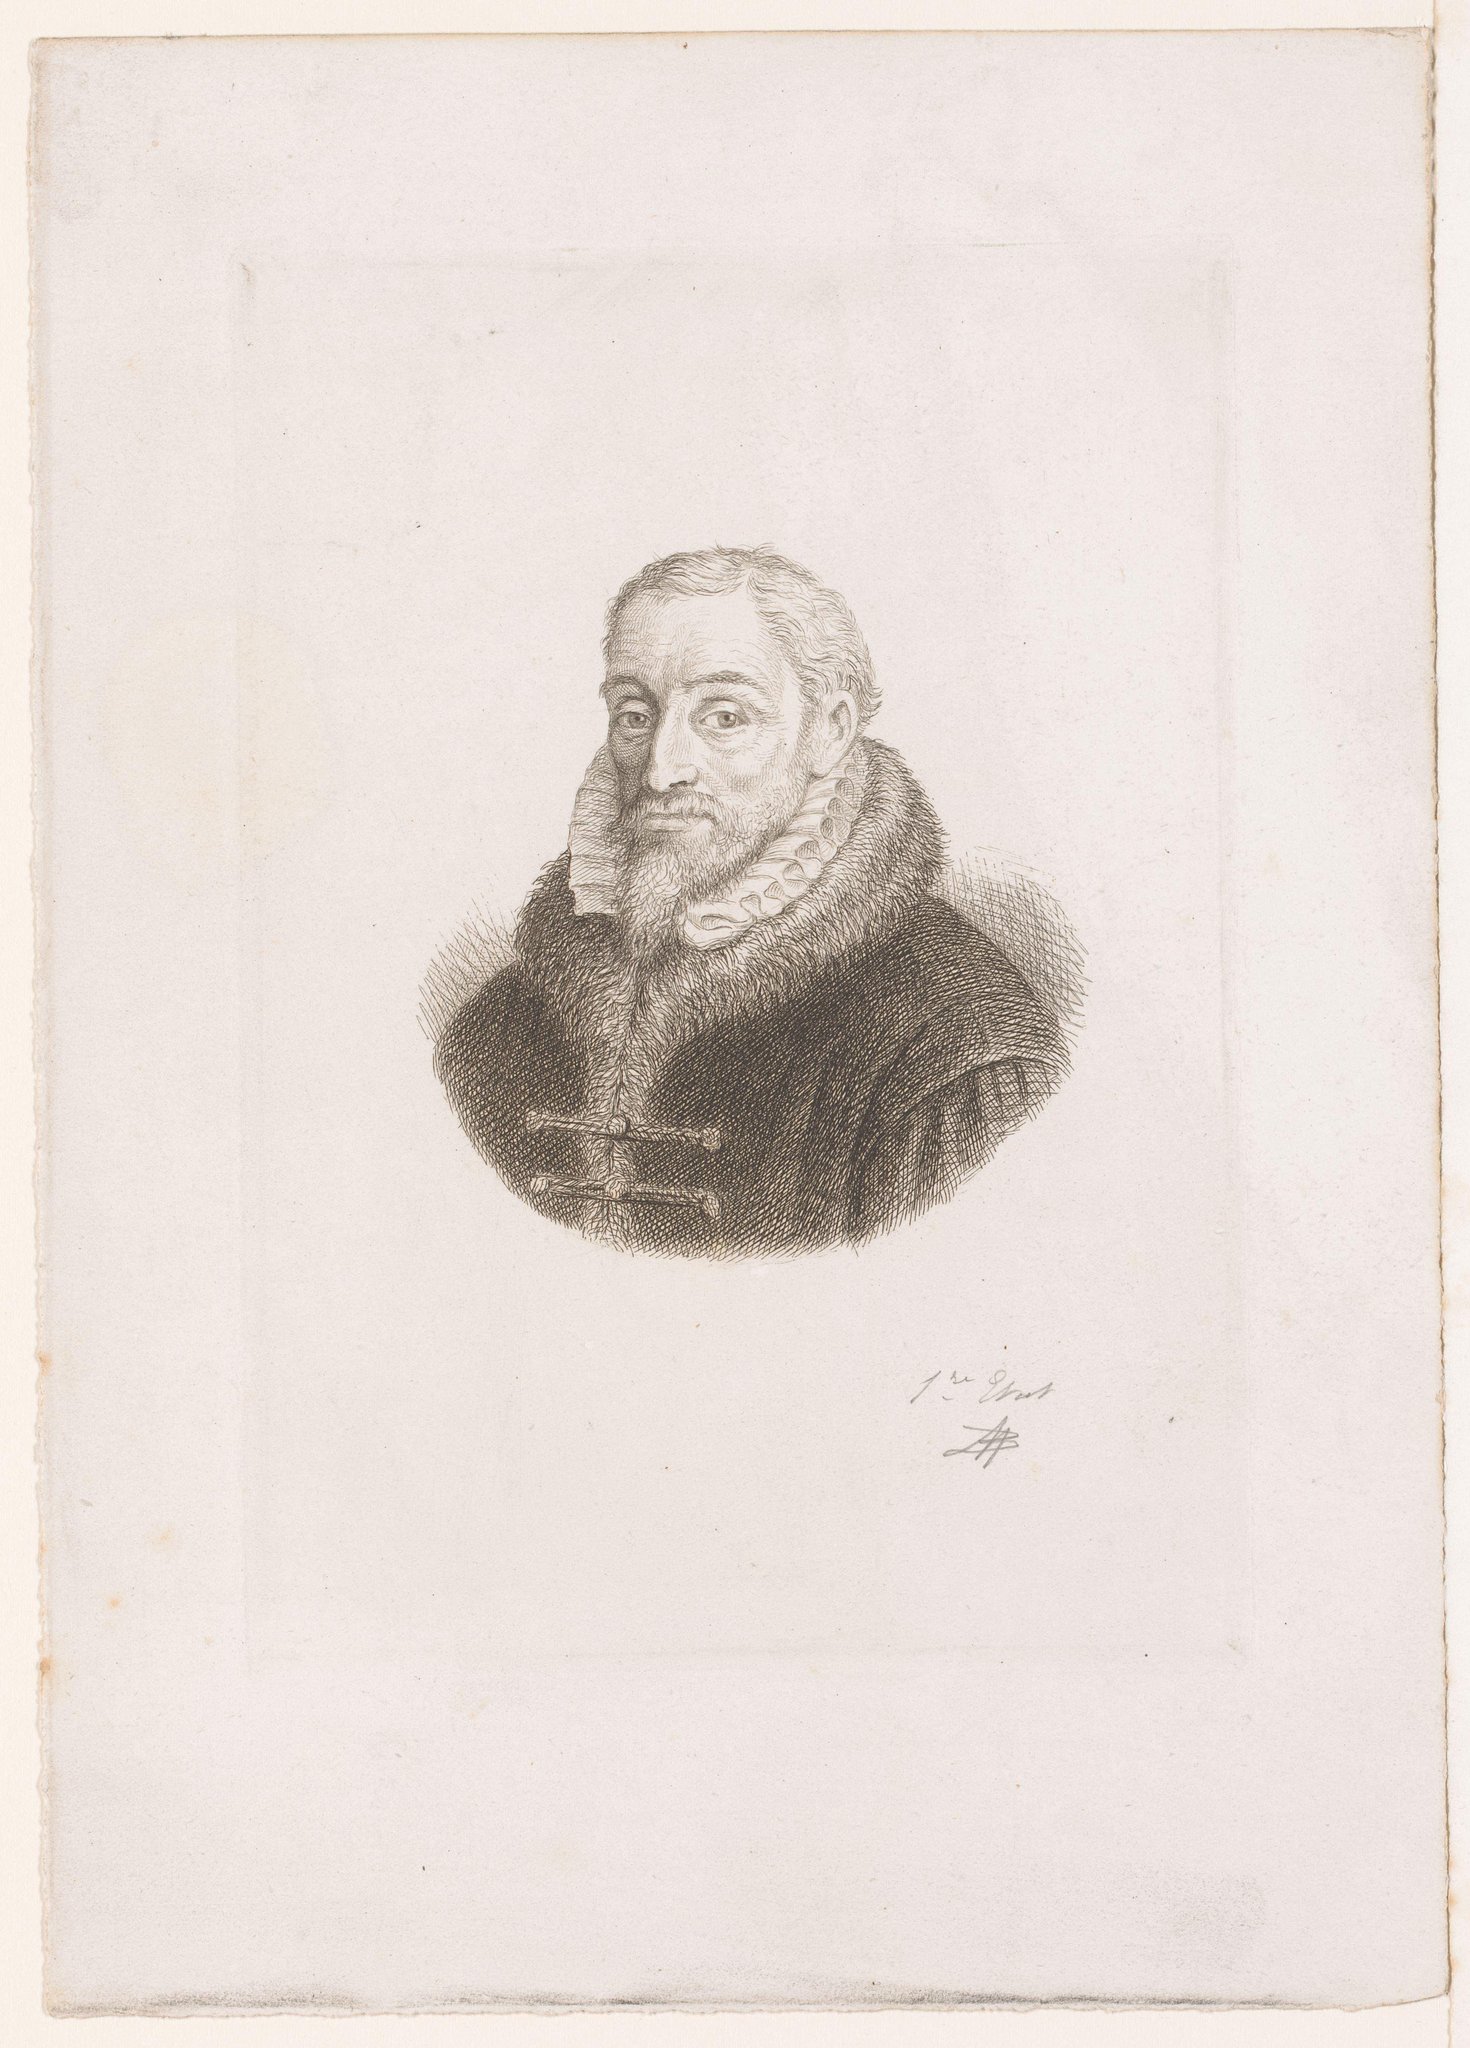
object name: print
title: Portret van Christoffel Plantijn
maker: jean baptiste pierre michiels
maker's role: print maker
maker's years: 1821-1890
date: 1881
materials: paper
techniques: etching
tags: publisher, christoffel plantijn, adult man, historical persons, beard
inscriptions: inscription: ‘1e Etat’, collector's mark: Lugt 2228